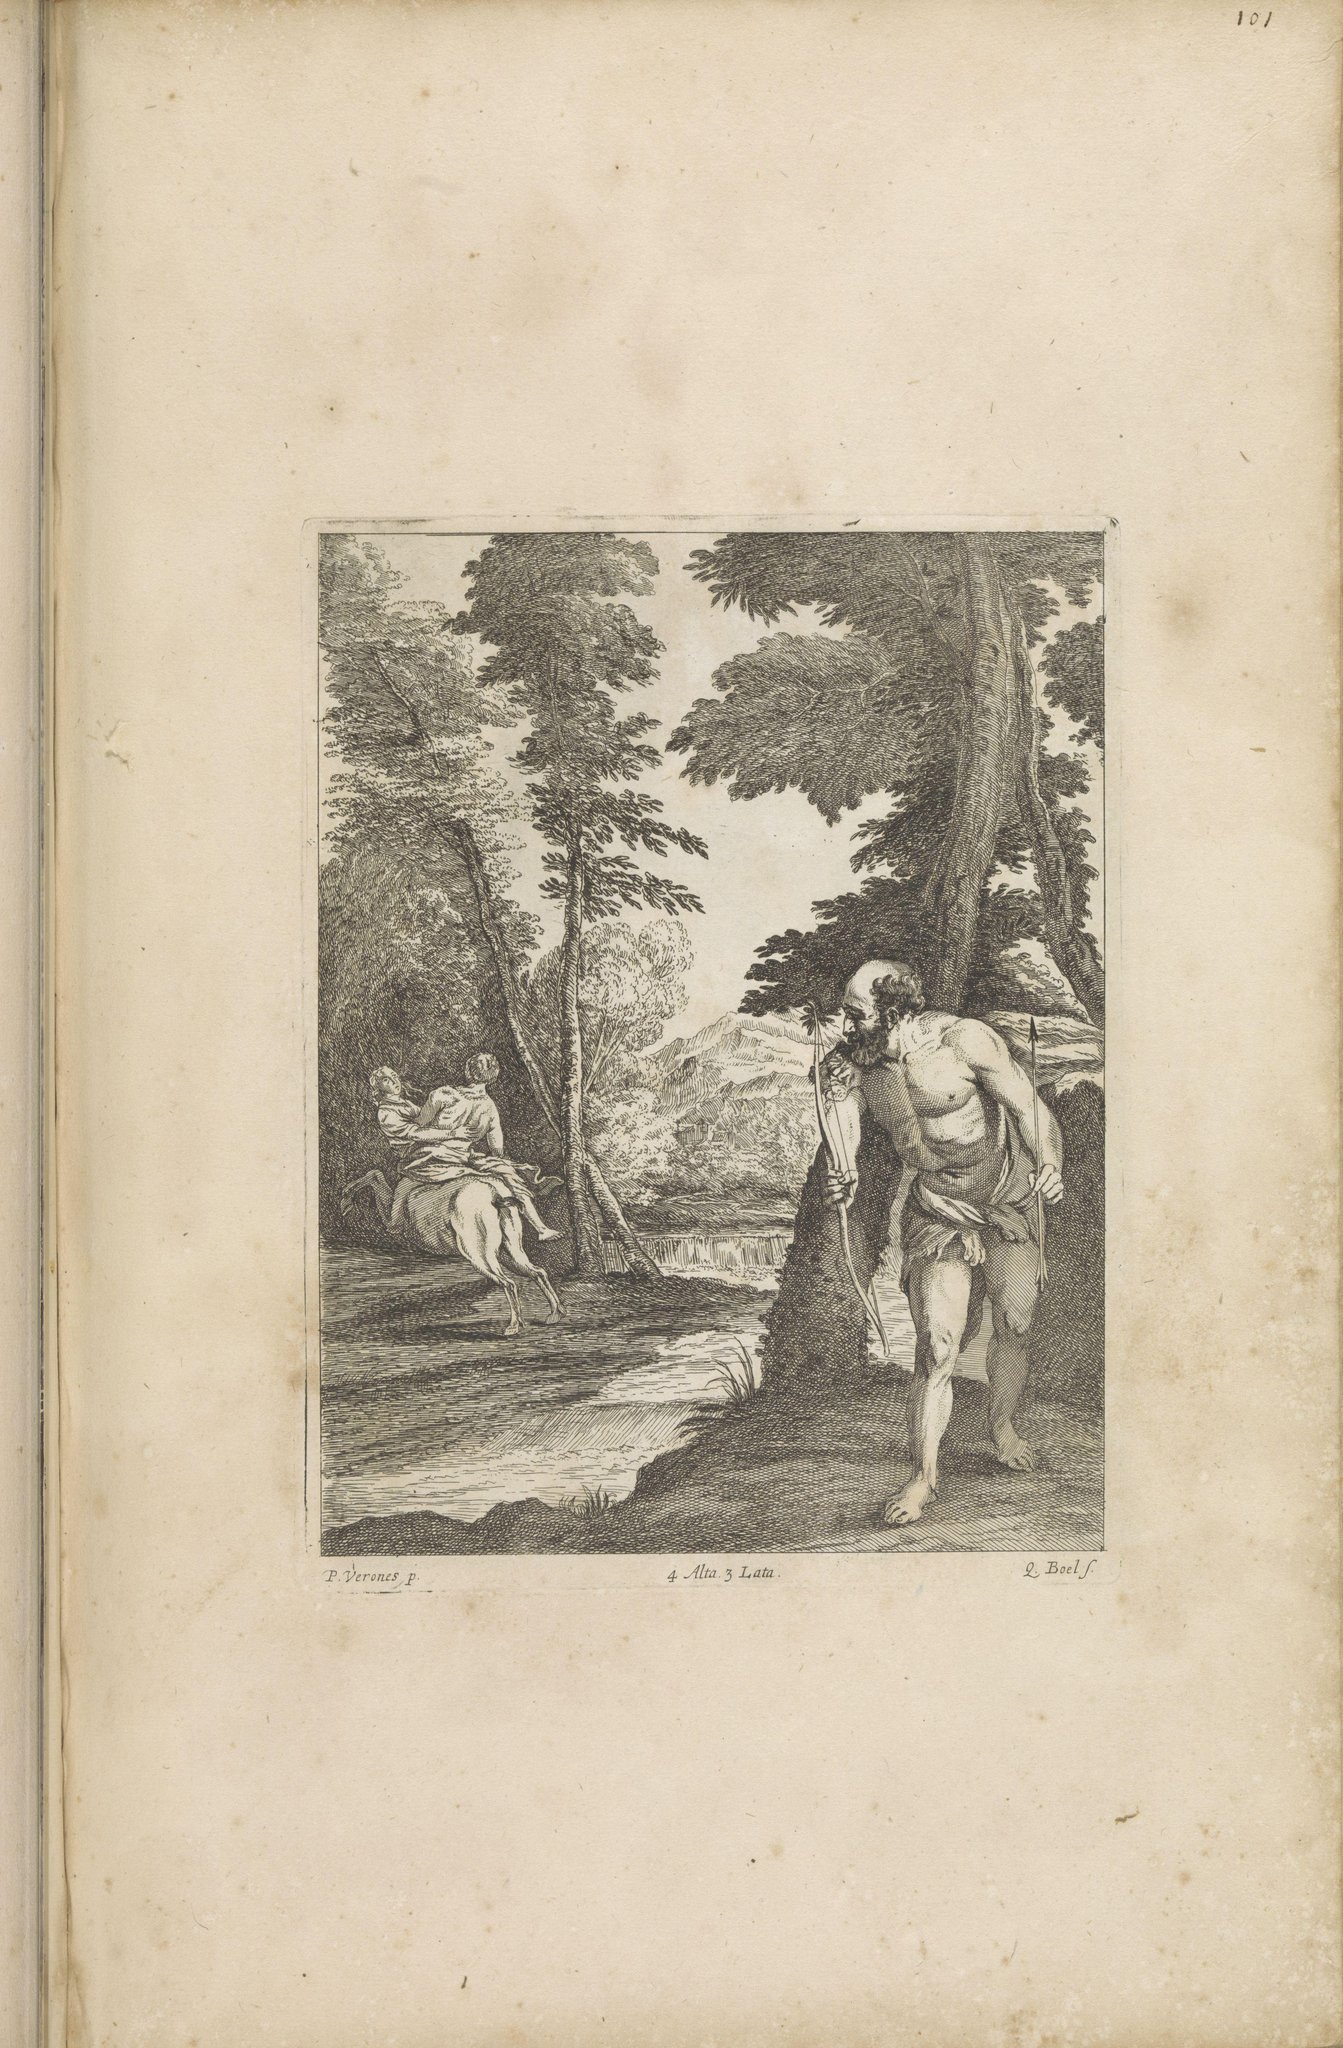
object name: album leaf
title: Ontvoering van Deïanira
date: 1660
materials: paper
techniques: etching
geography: brussels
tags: hercules shoots nessus, the centaur, who attempts to carry off deianira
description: De prent is vervaardigd naar het schilderij van Veronese dat zich in de collectie van het Kunsthistorisches Museum te Wenen bevindt (inventarisnummer GG_1525). David Teniers heeft waarschijnlijk van alle schilderijen uit de collectie van Leopold Willem van Oostenrijk een olieverfstudie op doek of paneel vervaardigd (zgn. pasticcio), die als voorbeeld voor de prentmakers diende. Het is niet altijd duidelijk of de pasticci door hem zijn gemaakt of door zijn atelier. Niet alle pasticci zijn overgeleverd.